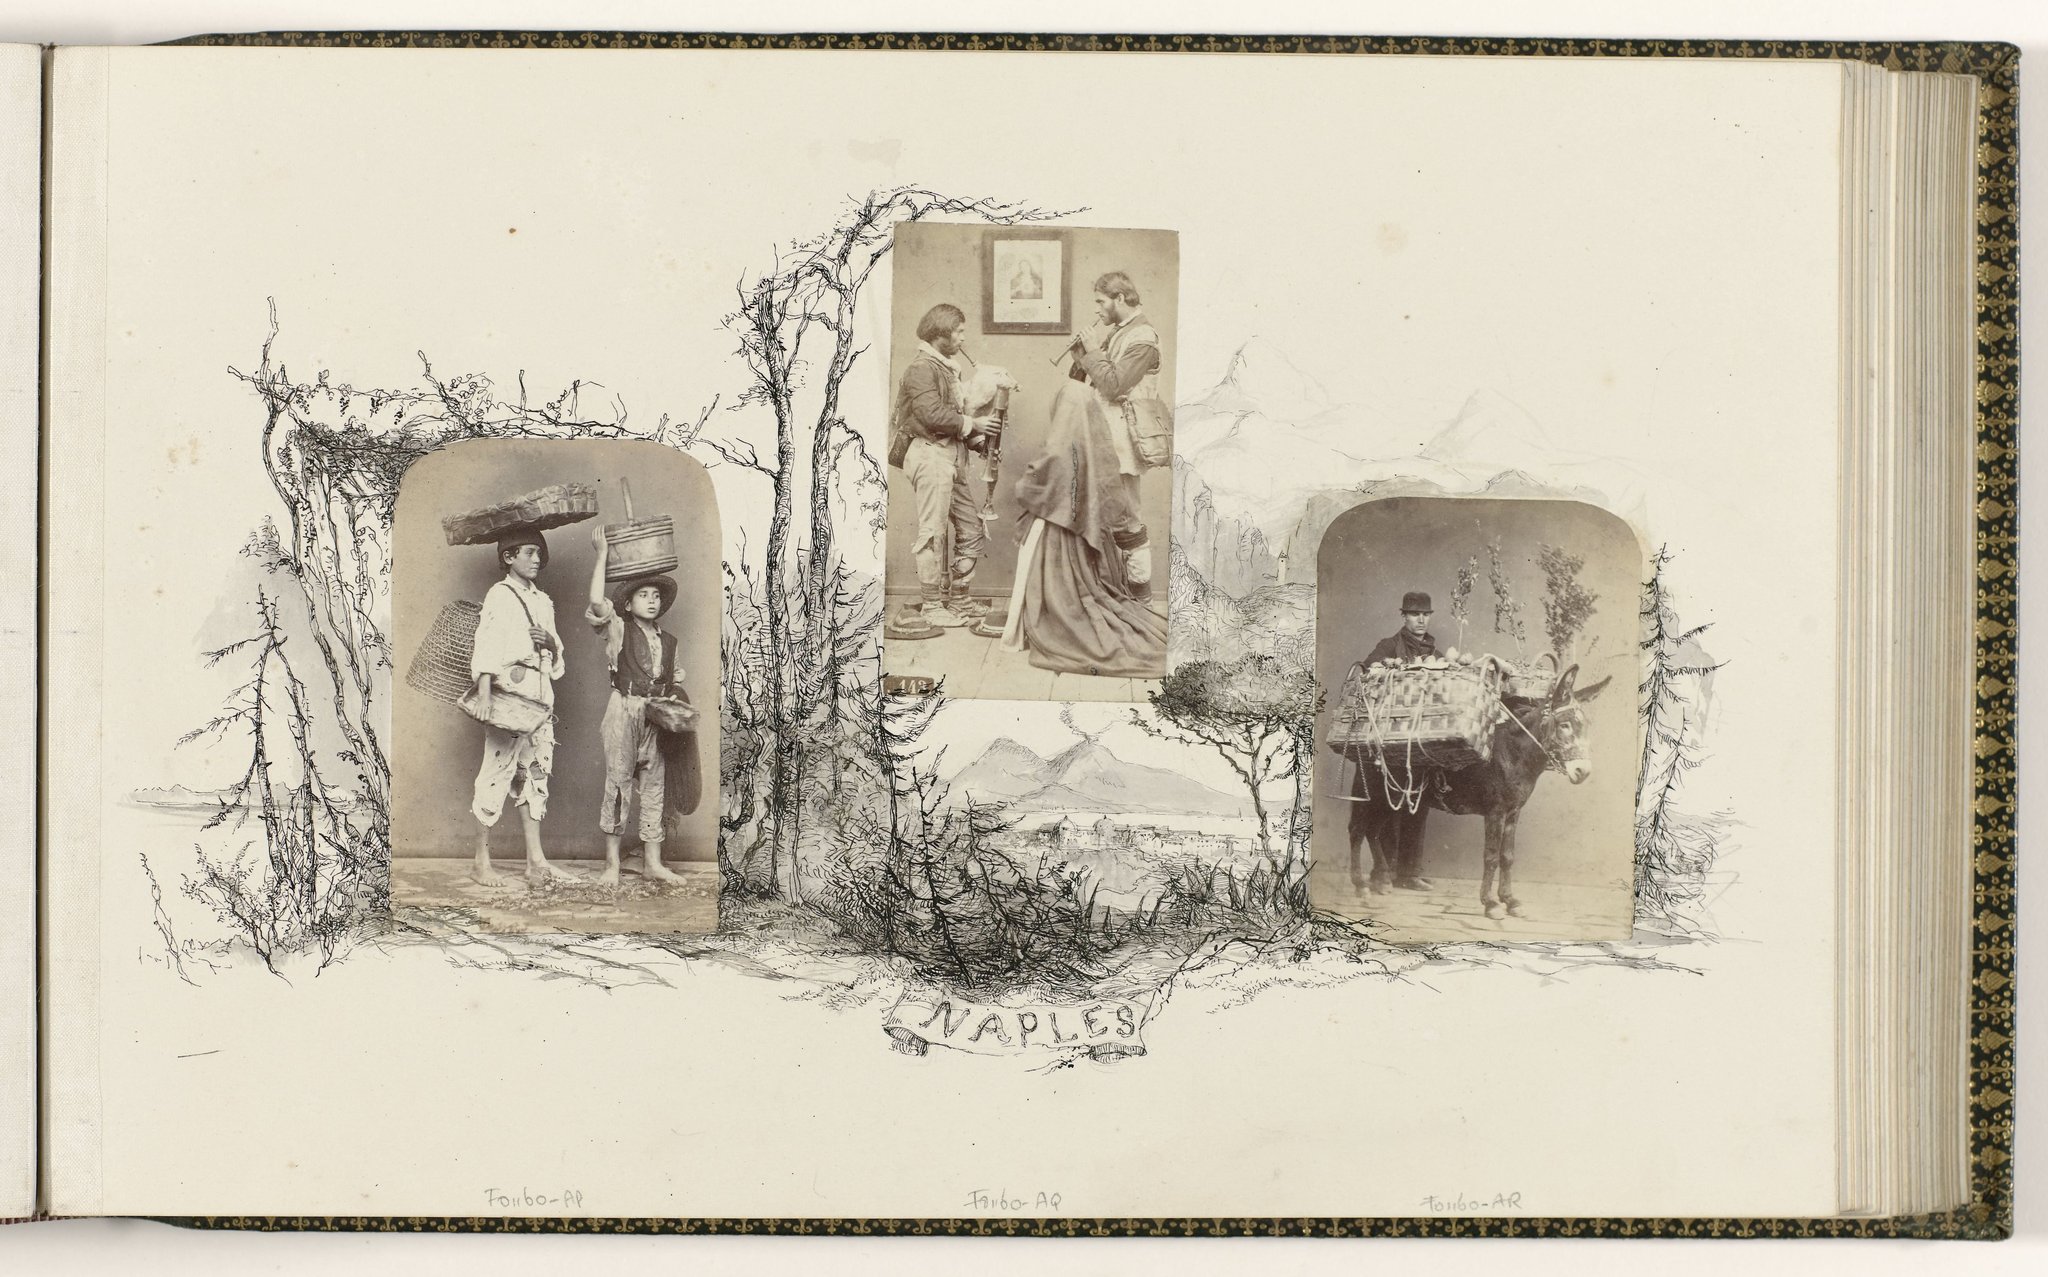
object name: album leaf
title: Fruitverkoper met beladen ezel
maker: Anonymous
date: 1865-1875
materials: paper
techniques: albumen print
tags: ass, donkey, merchant, salesman, naples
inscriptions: inscription: ‘NAPLES’